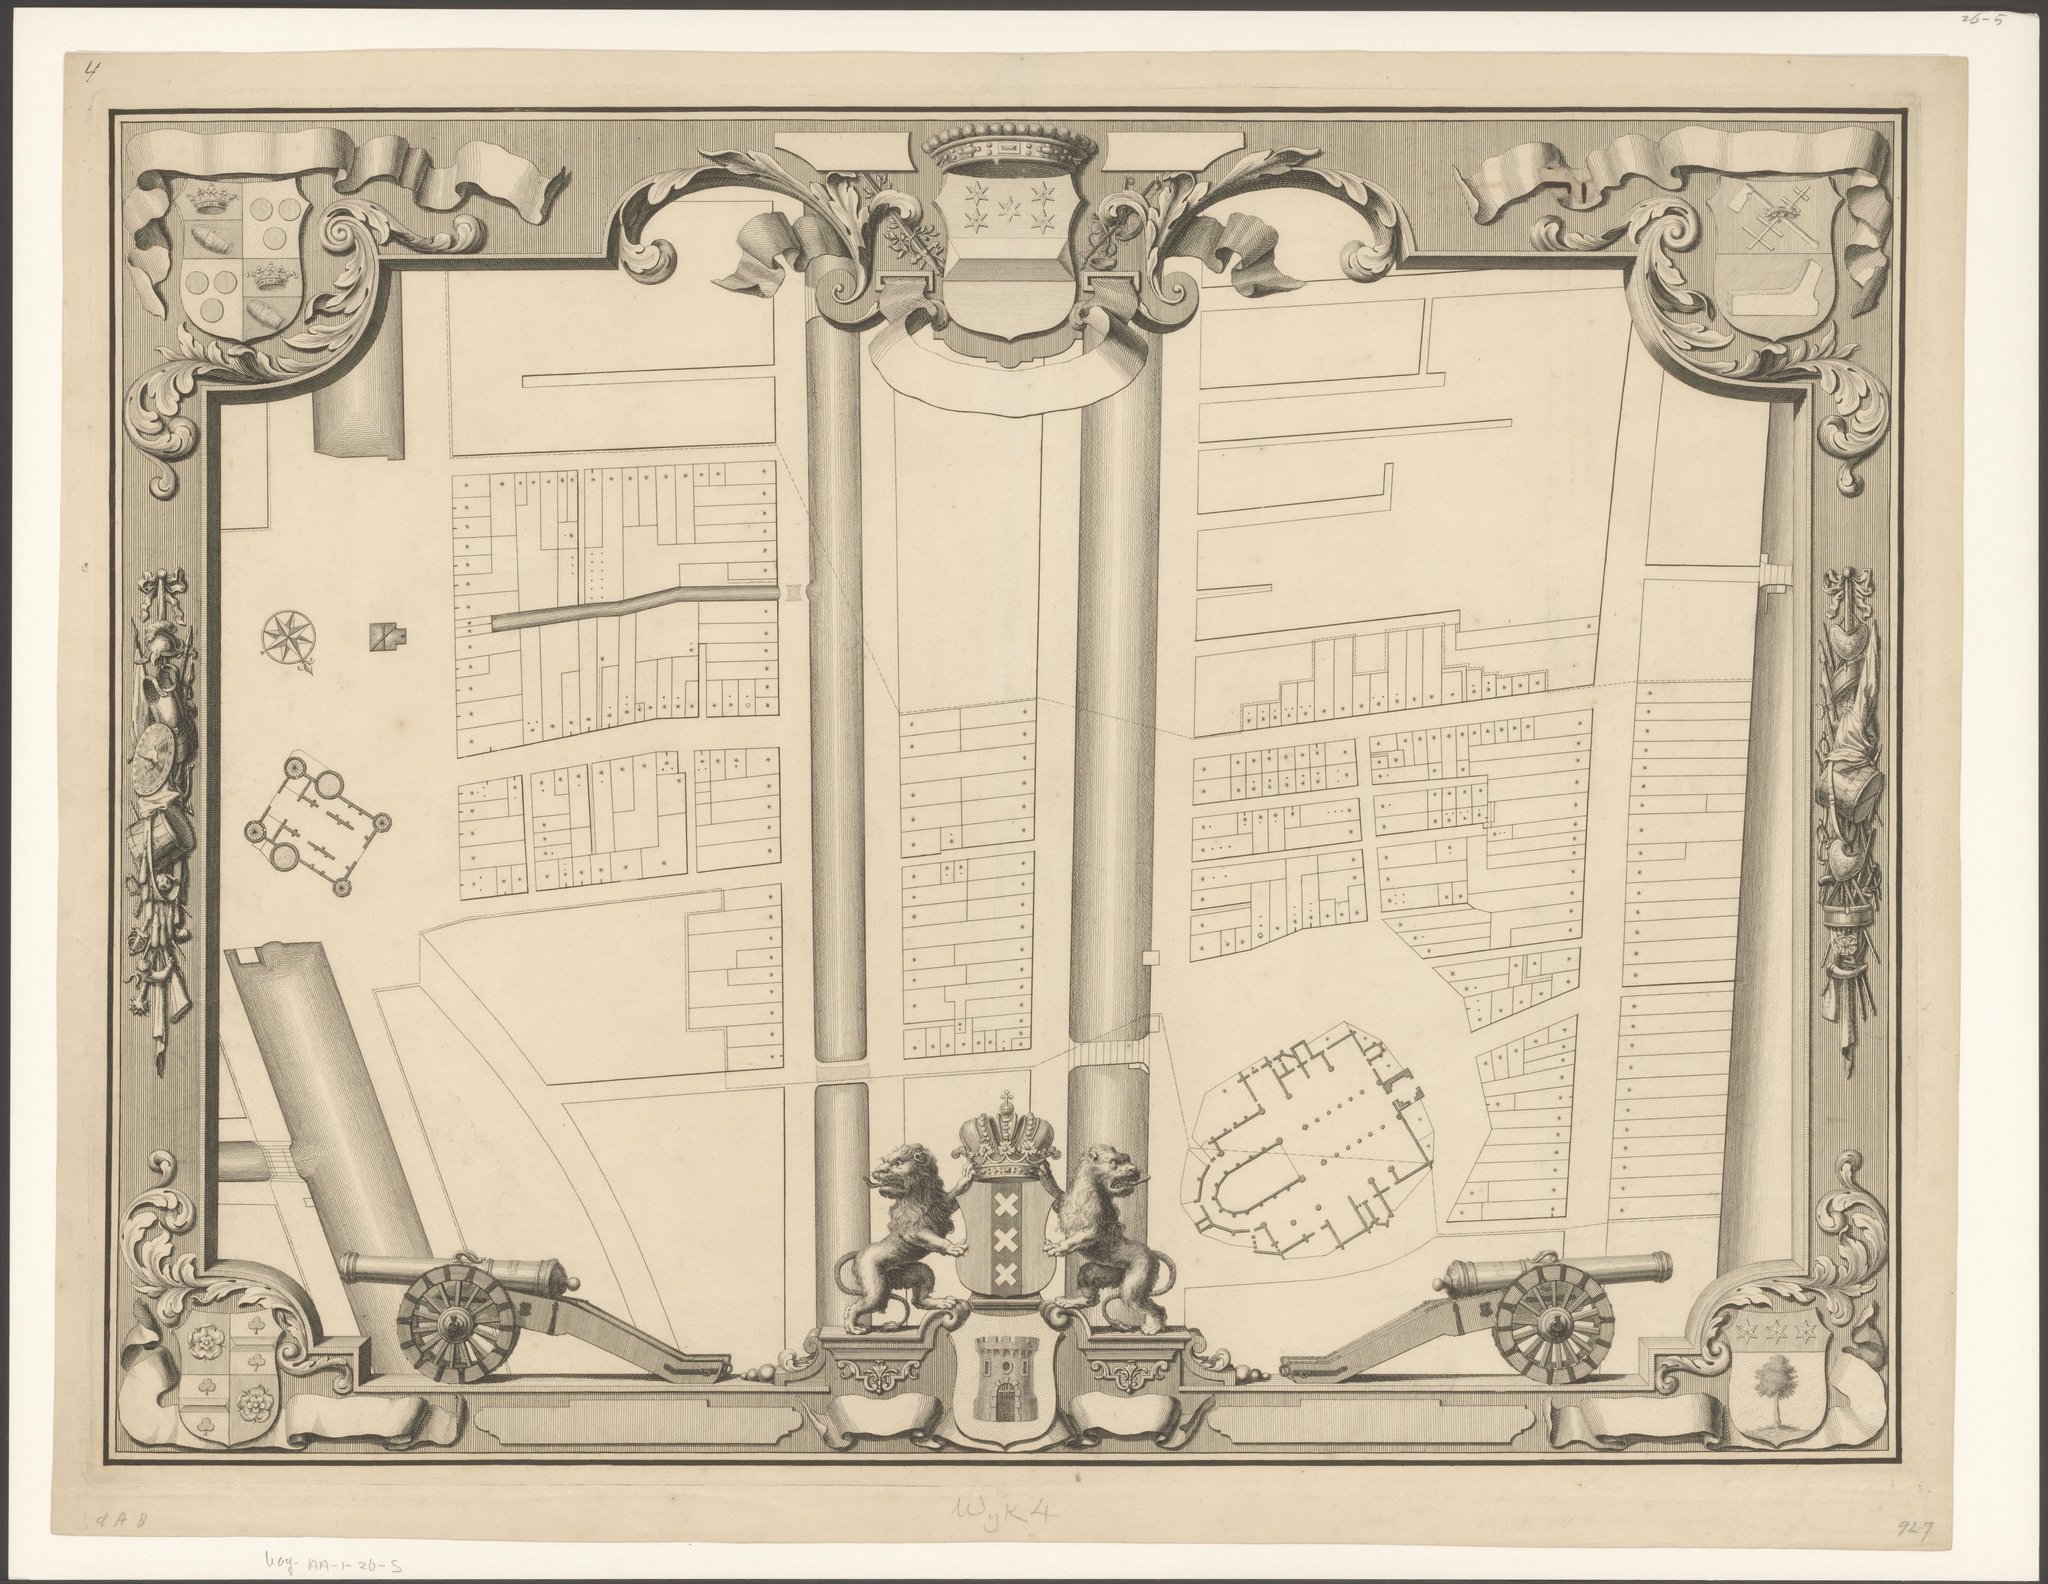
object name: area plan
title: Plattegrond van burgerwijk IV te Amsterdam, onder leiding van kapitein Gerard van Papenbroeck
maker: jan caspar philips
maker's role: draughtsman, print maker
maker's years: 1700-1775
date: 1743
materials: paper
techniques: engraving, etching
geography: amsterdam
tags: coat of arms (as symbol of the state, etc.) (+ city; municipal), firearms: cannon, maps of cities, armorial bearing, heraldry, amsterdam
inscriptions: collector's mark: Lugt 1641b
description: Bovenaan, van links naar rechts, de wapens van luitenant Jan Colonius, kapitein Gerard van Papenbroeck en vaandrig Jacob van der Werf. Onderaan, van links naar rechts, de wapens van de sergeanten Clement Wolffers, Gerard Burgers en Matthys Houtman. Centraal onderaan het wapen van Amsterdam met twee leeuwen als schildhouders. Onderwerpsrubriek binnen de Atlas Amsterdam: Schutterswijkkaarten.